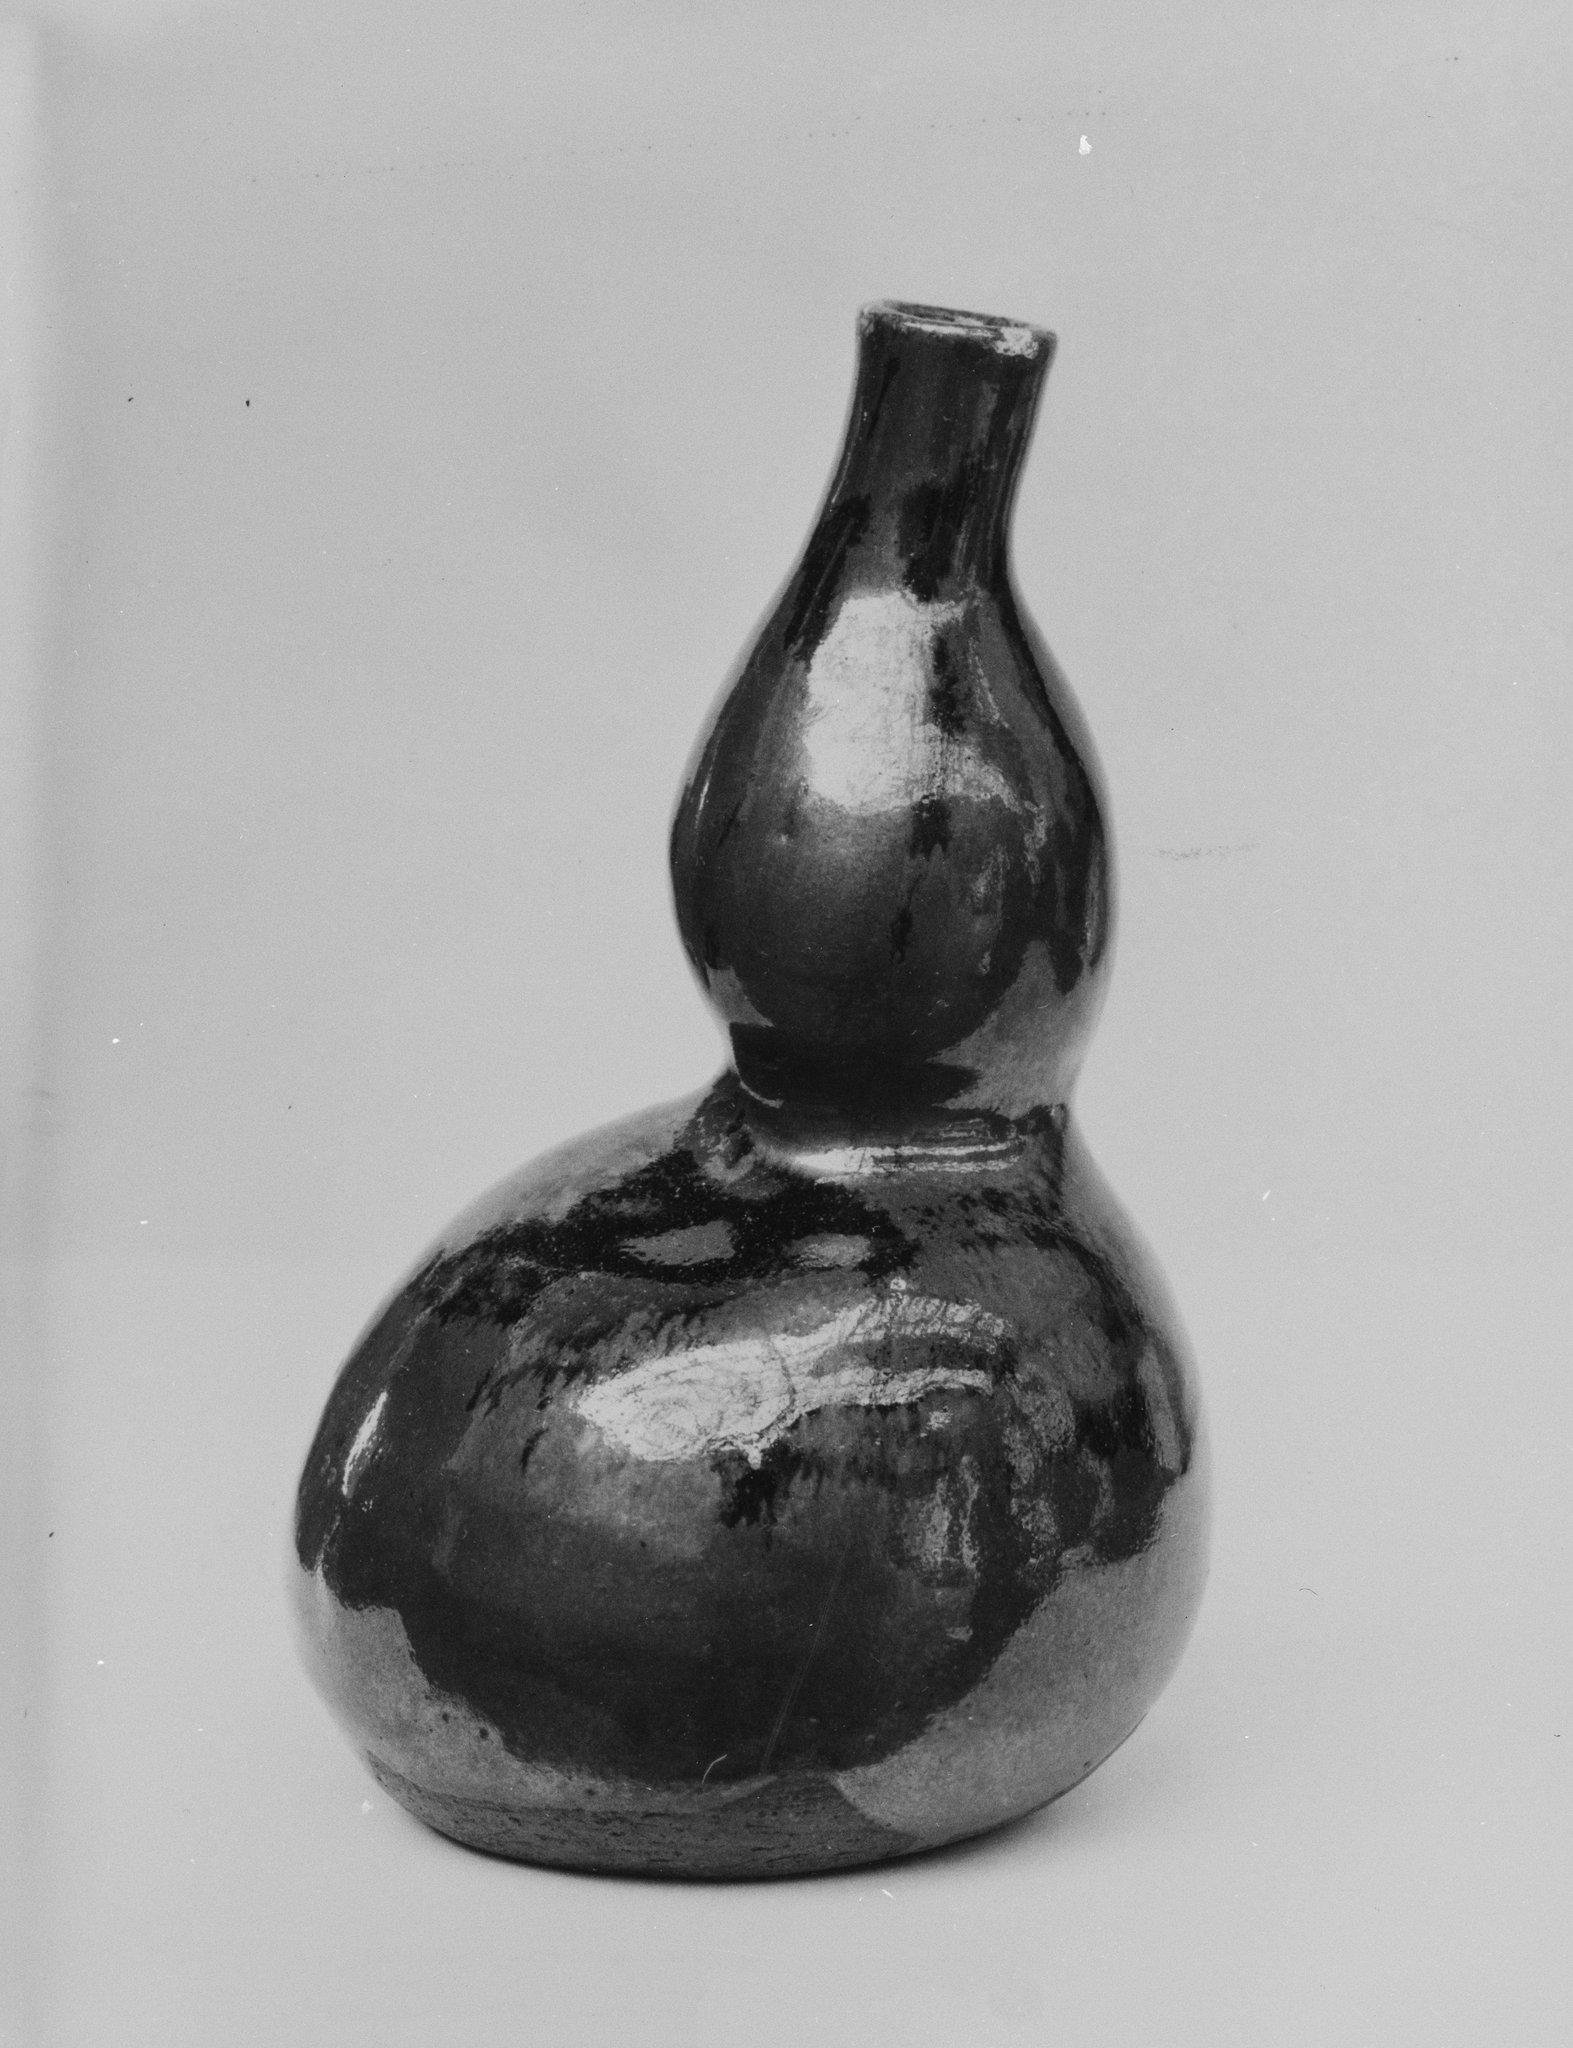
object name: wine bottle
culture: japanese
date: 1701-1800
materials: glaze, pottery